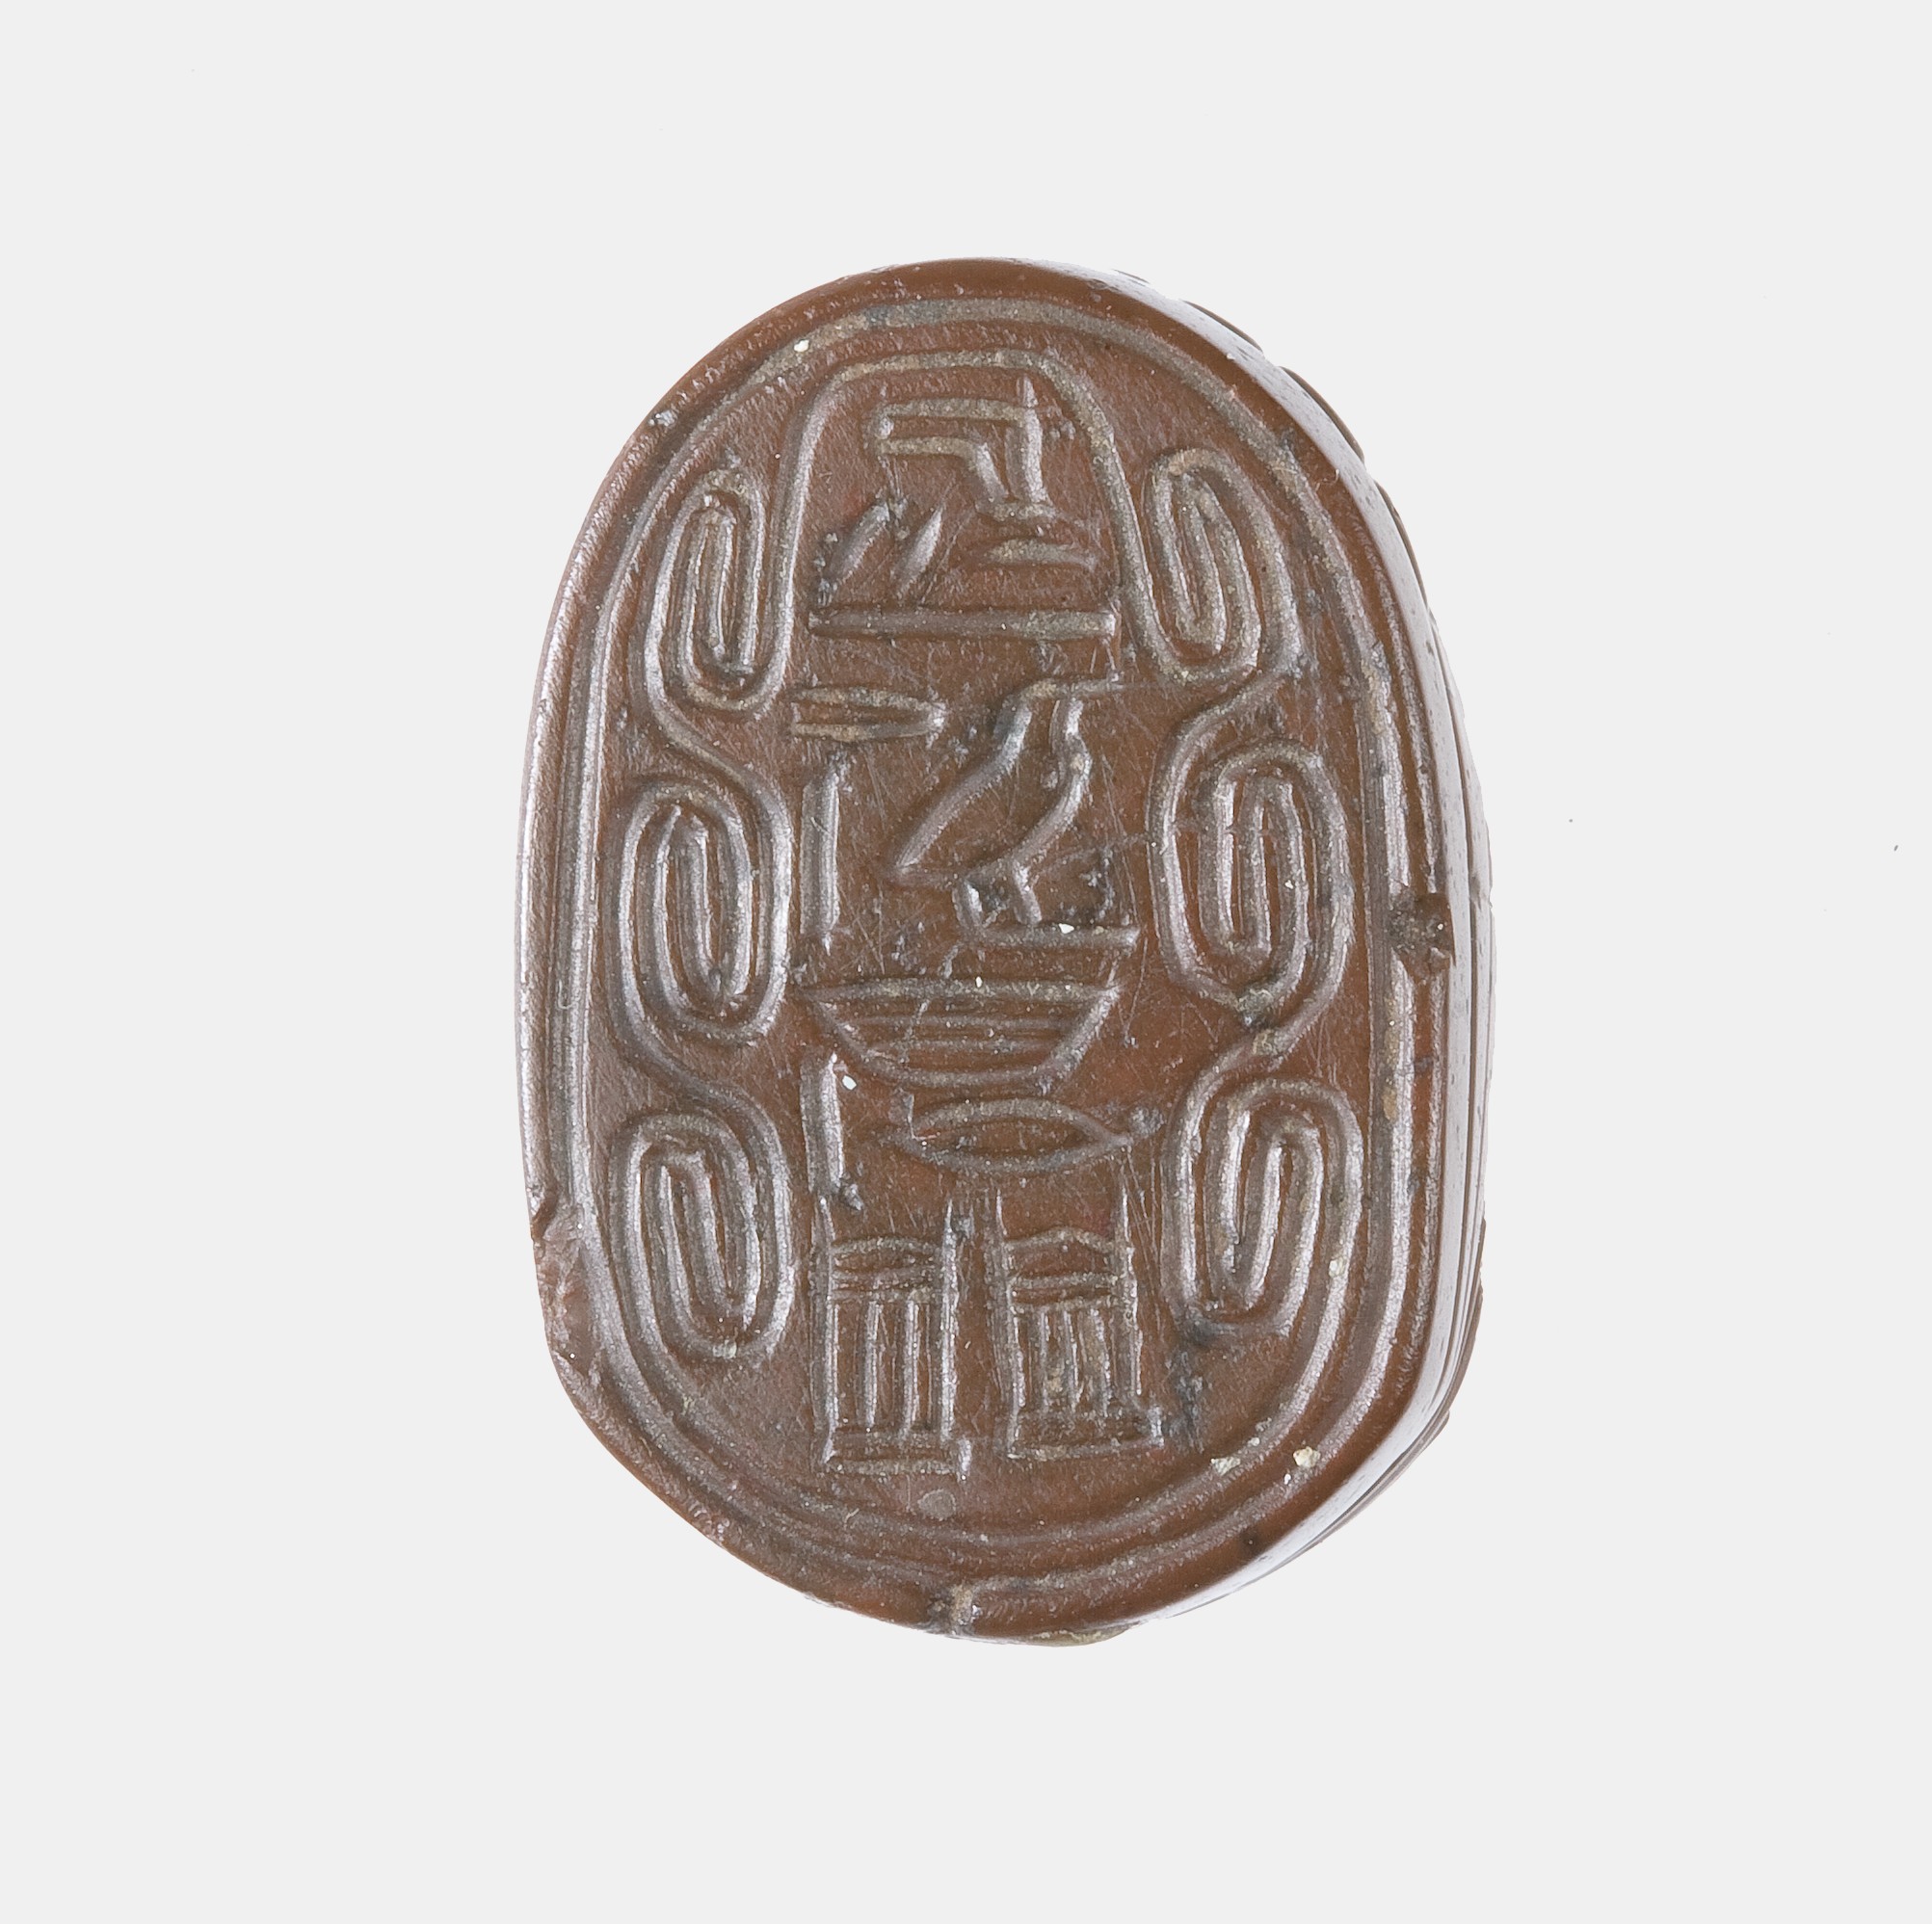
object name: scarab, nebrasahwy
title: Scarab Inscribed for Nebrasahwy, the magistrate of a district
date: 1850-1700 BCE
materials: jasper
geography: egypt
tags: hieroglyphs,scarabs